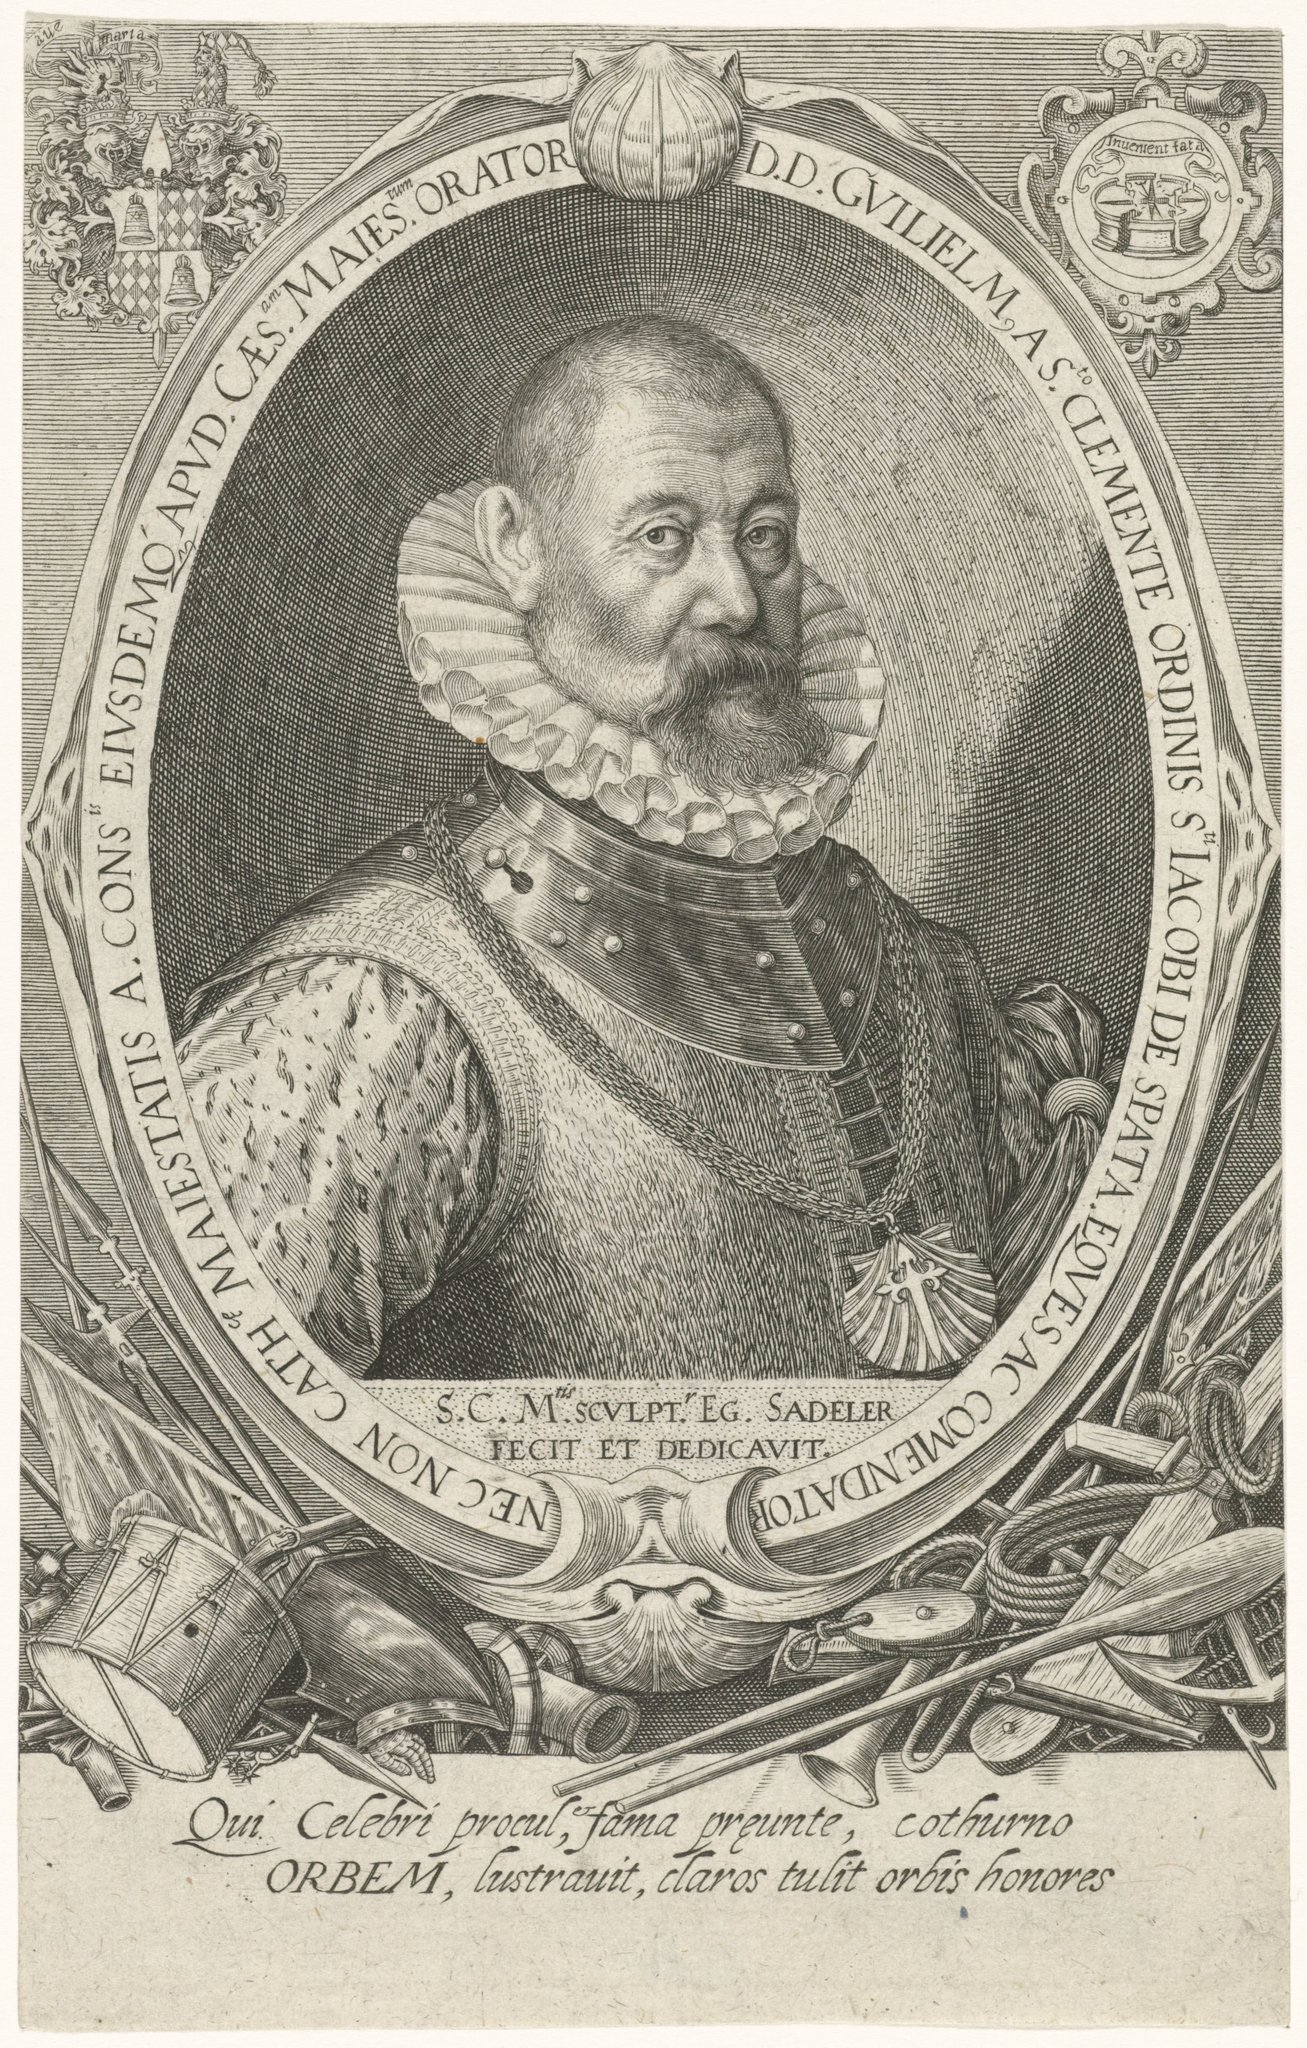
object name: print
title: Portret van Guillén de San Clemente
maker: aegidius sadeler (ii)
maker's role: draughtsman, print maker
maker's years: 1568-1629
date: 1597-1608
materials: paper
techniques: engraving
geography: prague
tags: ambassadeur, guillén de san clemente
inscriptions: collector's mark: Lugt 2228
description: Guillén de San Clemente, Spaanse ambassadeur aan het keizerlijk hof van Rudolf II. Onder het portret allerlei wapentuig en een Latijns onderschrift.